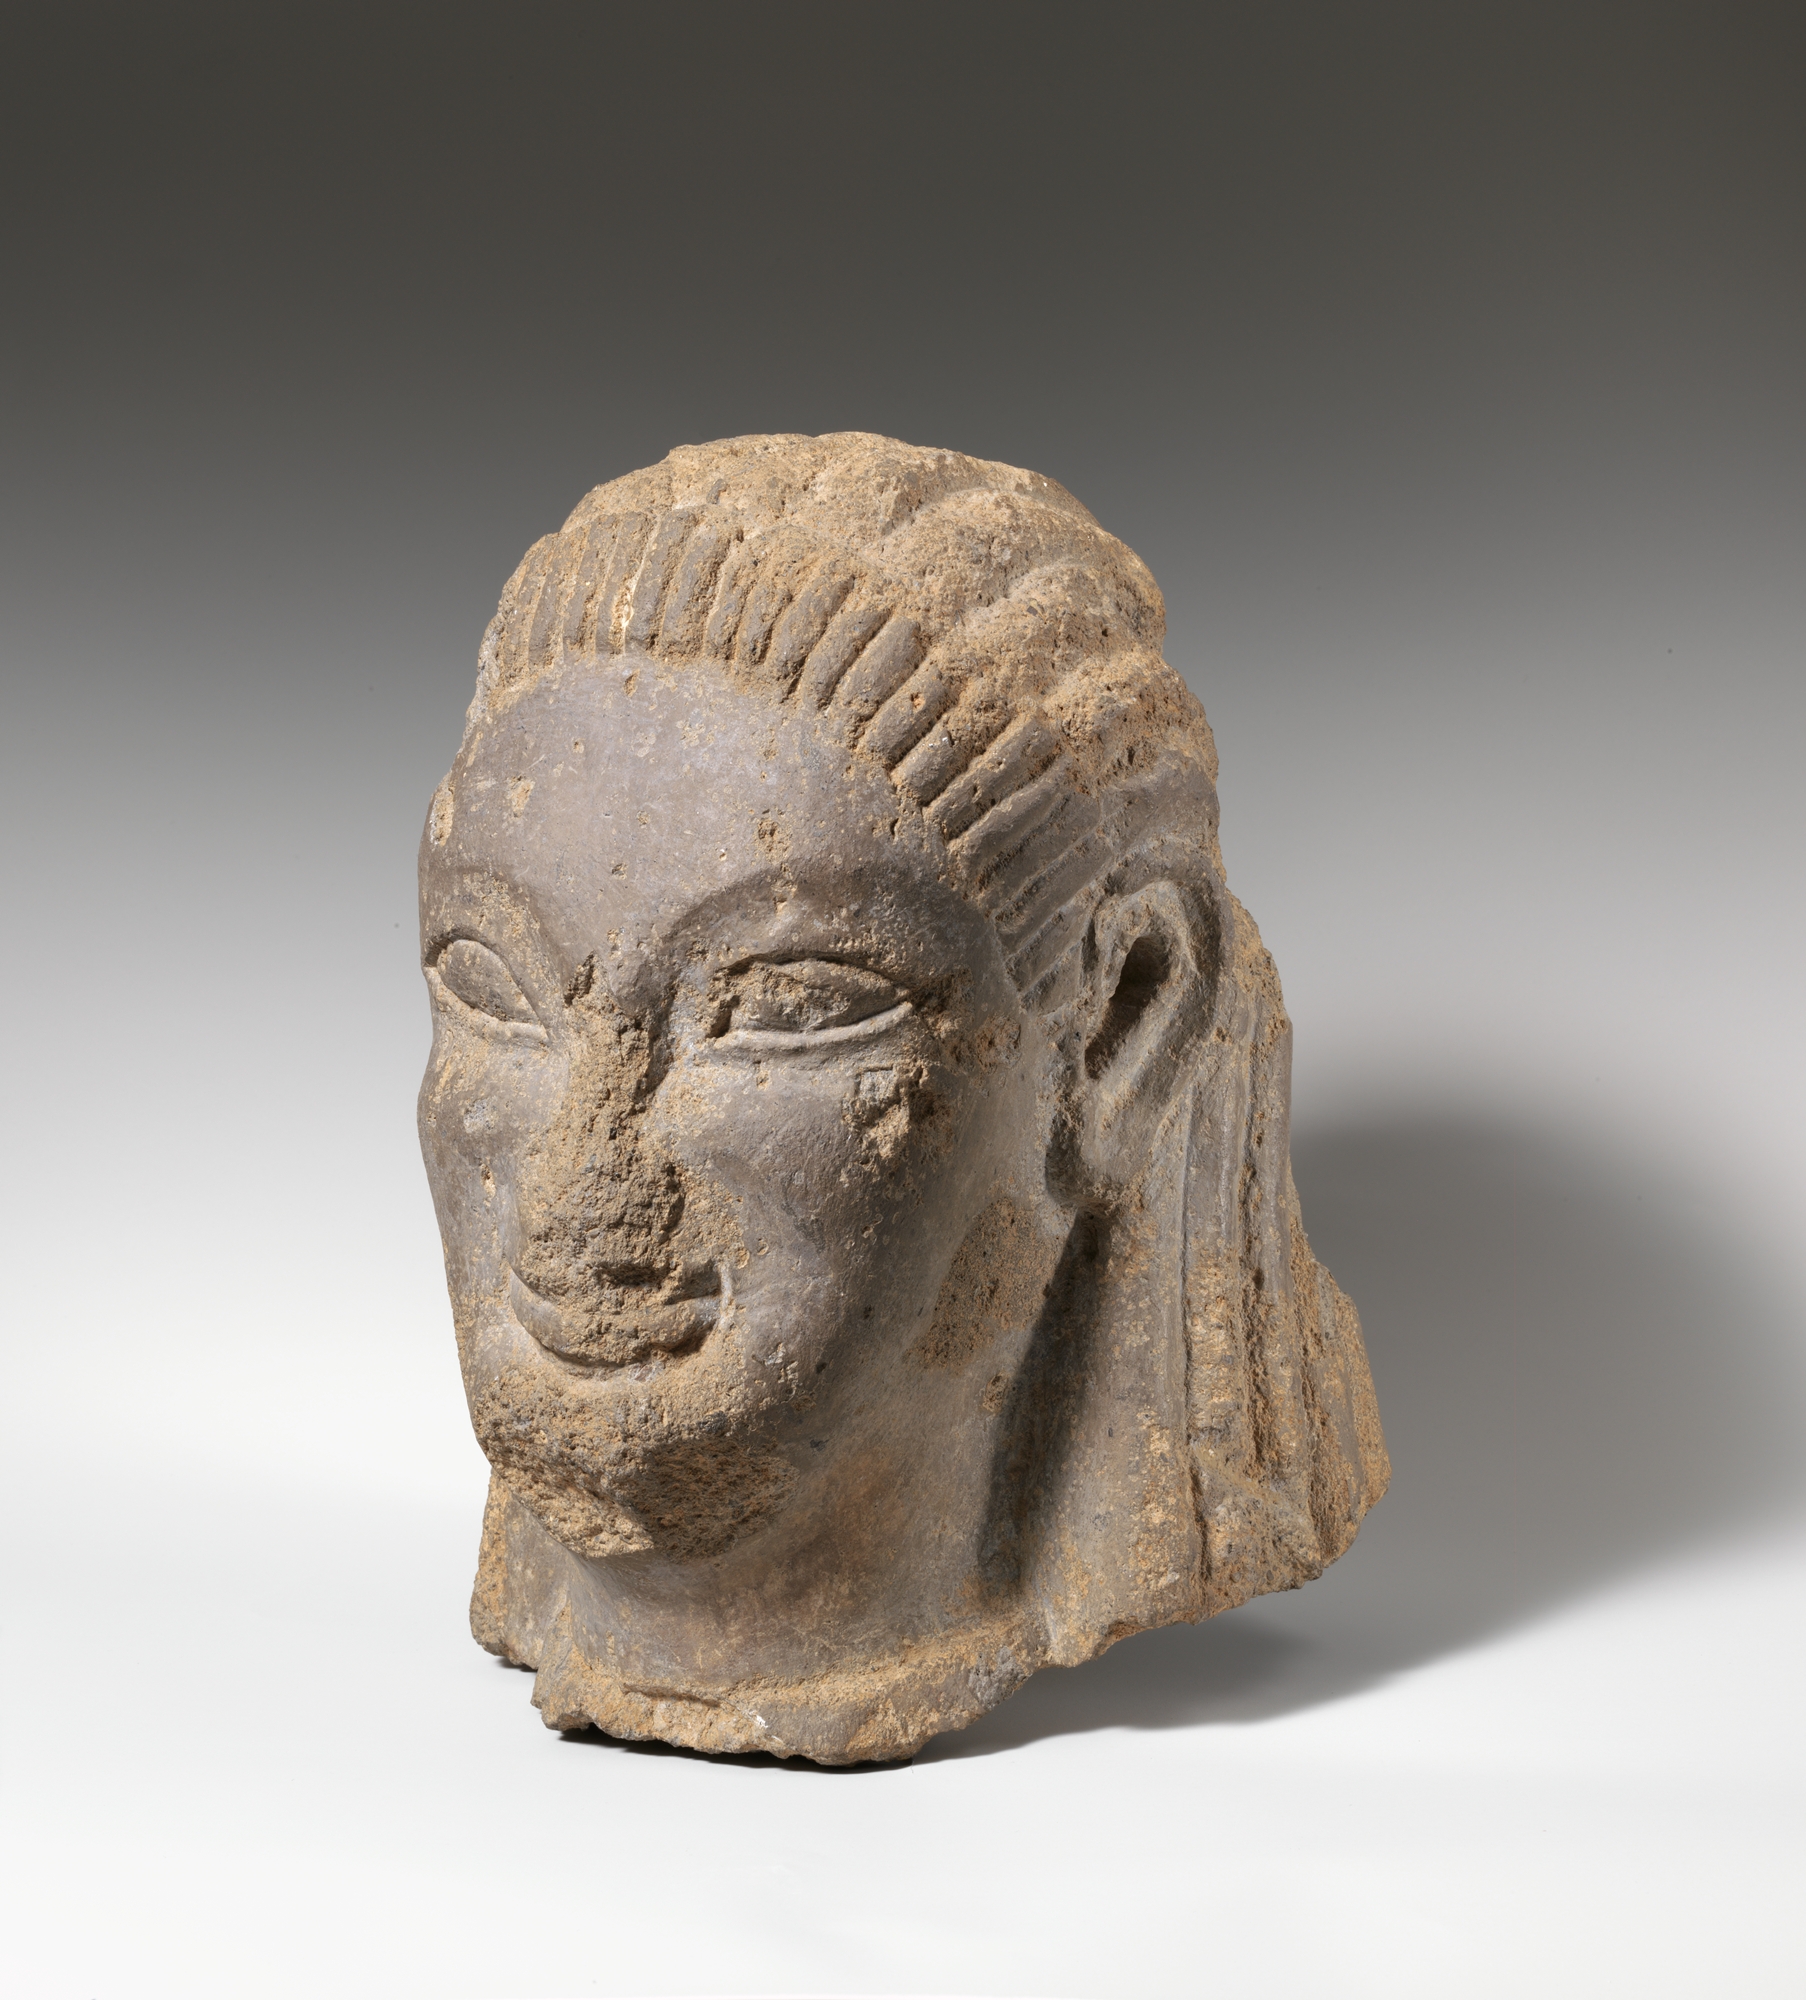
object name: head of a sphinx or siren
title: Tufa head of sphinx or siren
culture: etruscan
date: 550-525 BCE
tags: sphinx,sirens